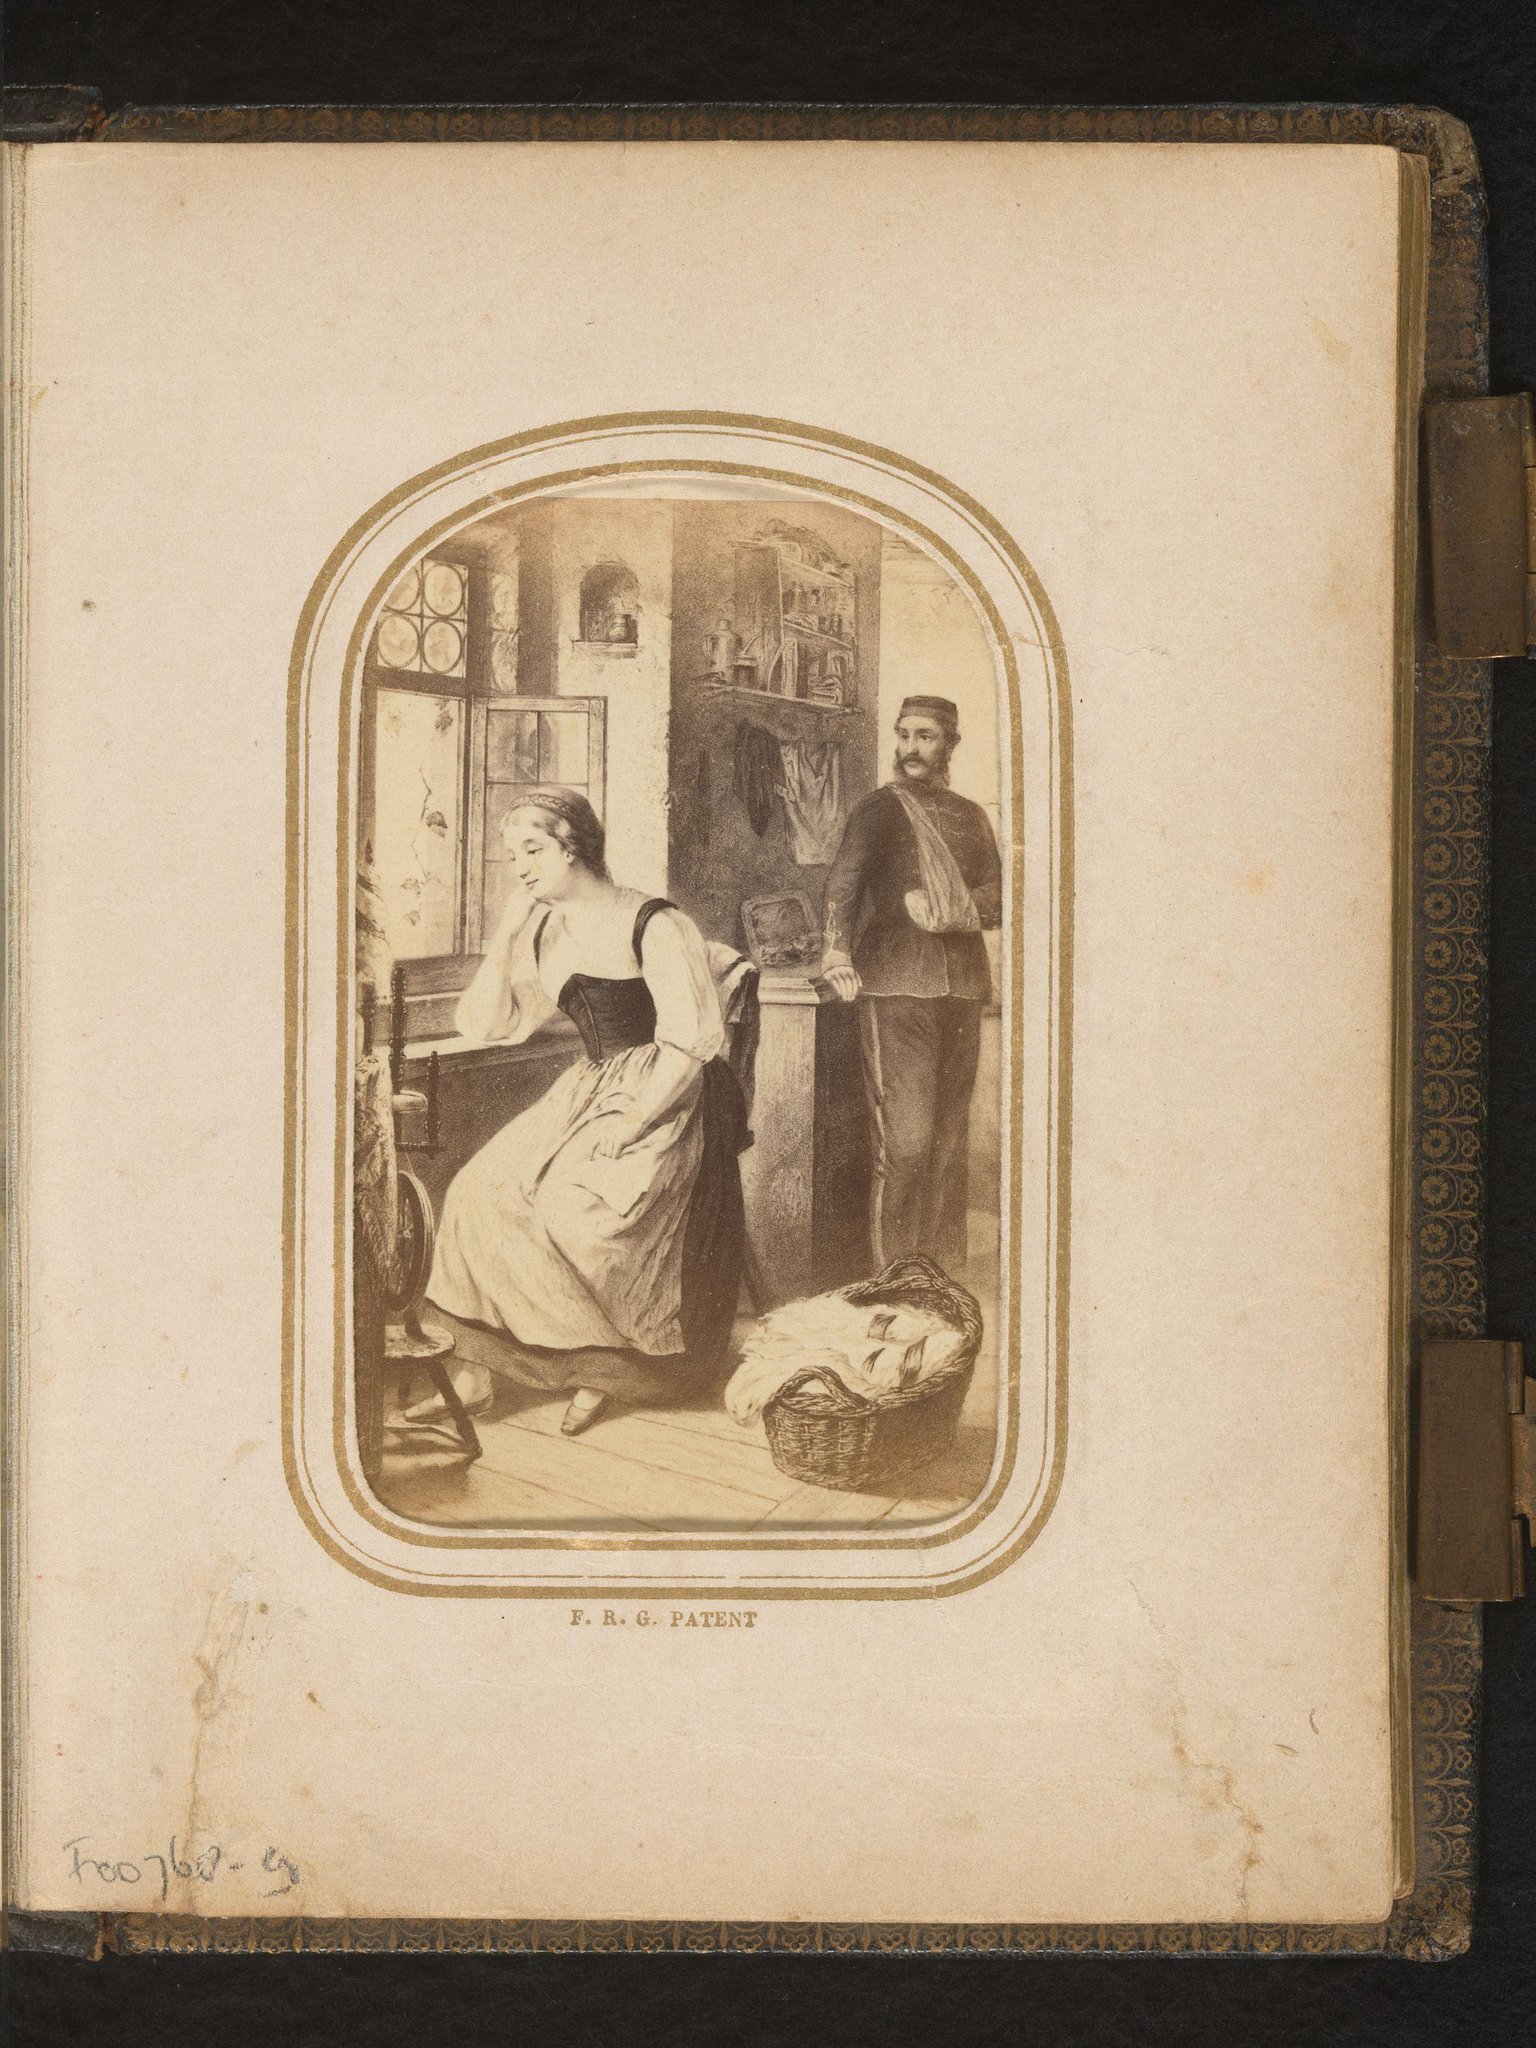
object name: album leaf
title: Fotoreproductie van een schilderij van een soldaat bij een vrouw en baby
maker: Anonymous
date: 1865-1890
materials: cardboard, photographic support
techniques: albumen print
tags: interior of the house, mother and baby or young child, the soldier; the soldier's life, painting, drawing and the graphic arts